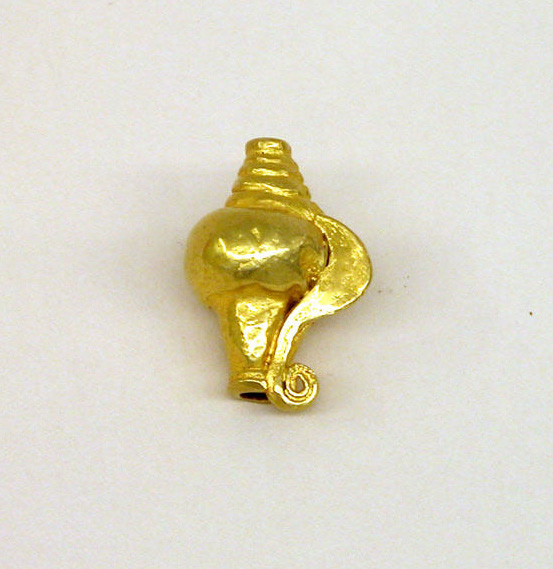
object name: pendant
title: Pendant in the Shape of a Shankha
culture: indonesian, javanese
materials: gold